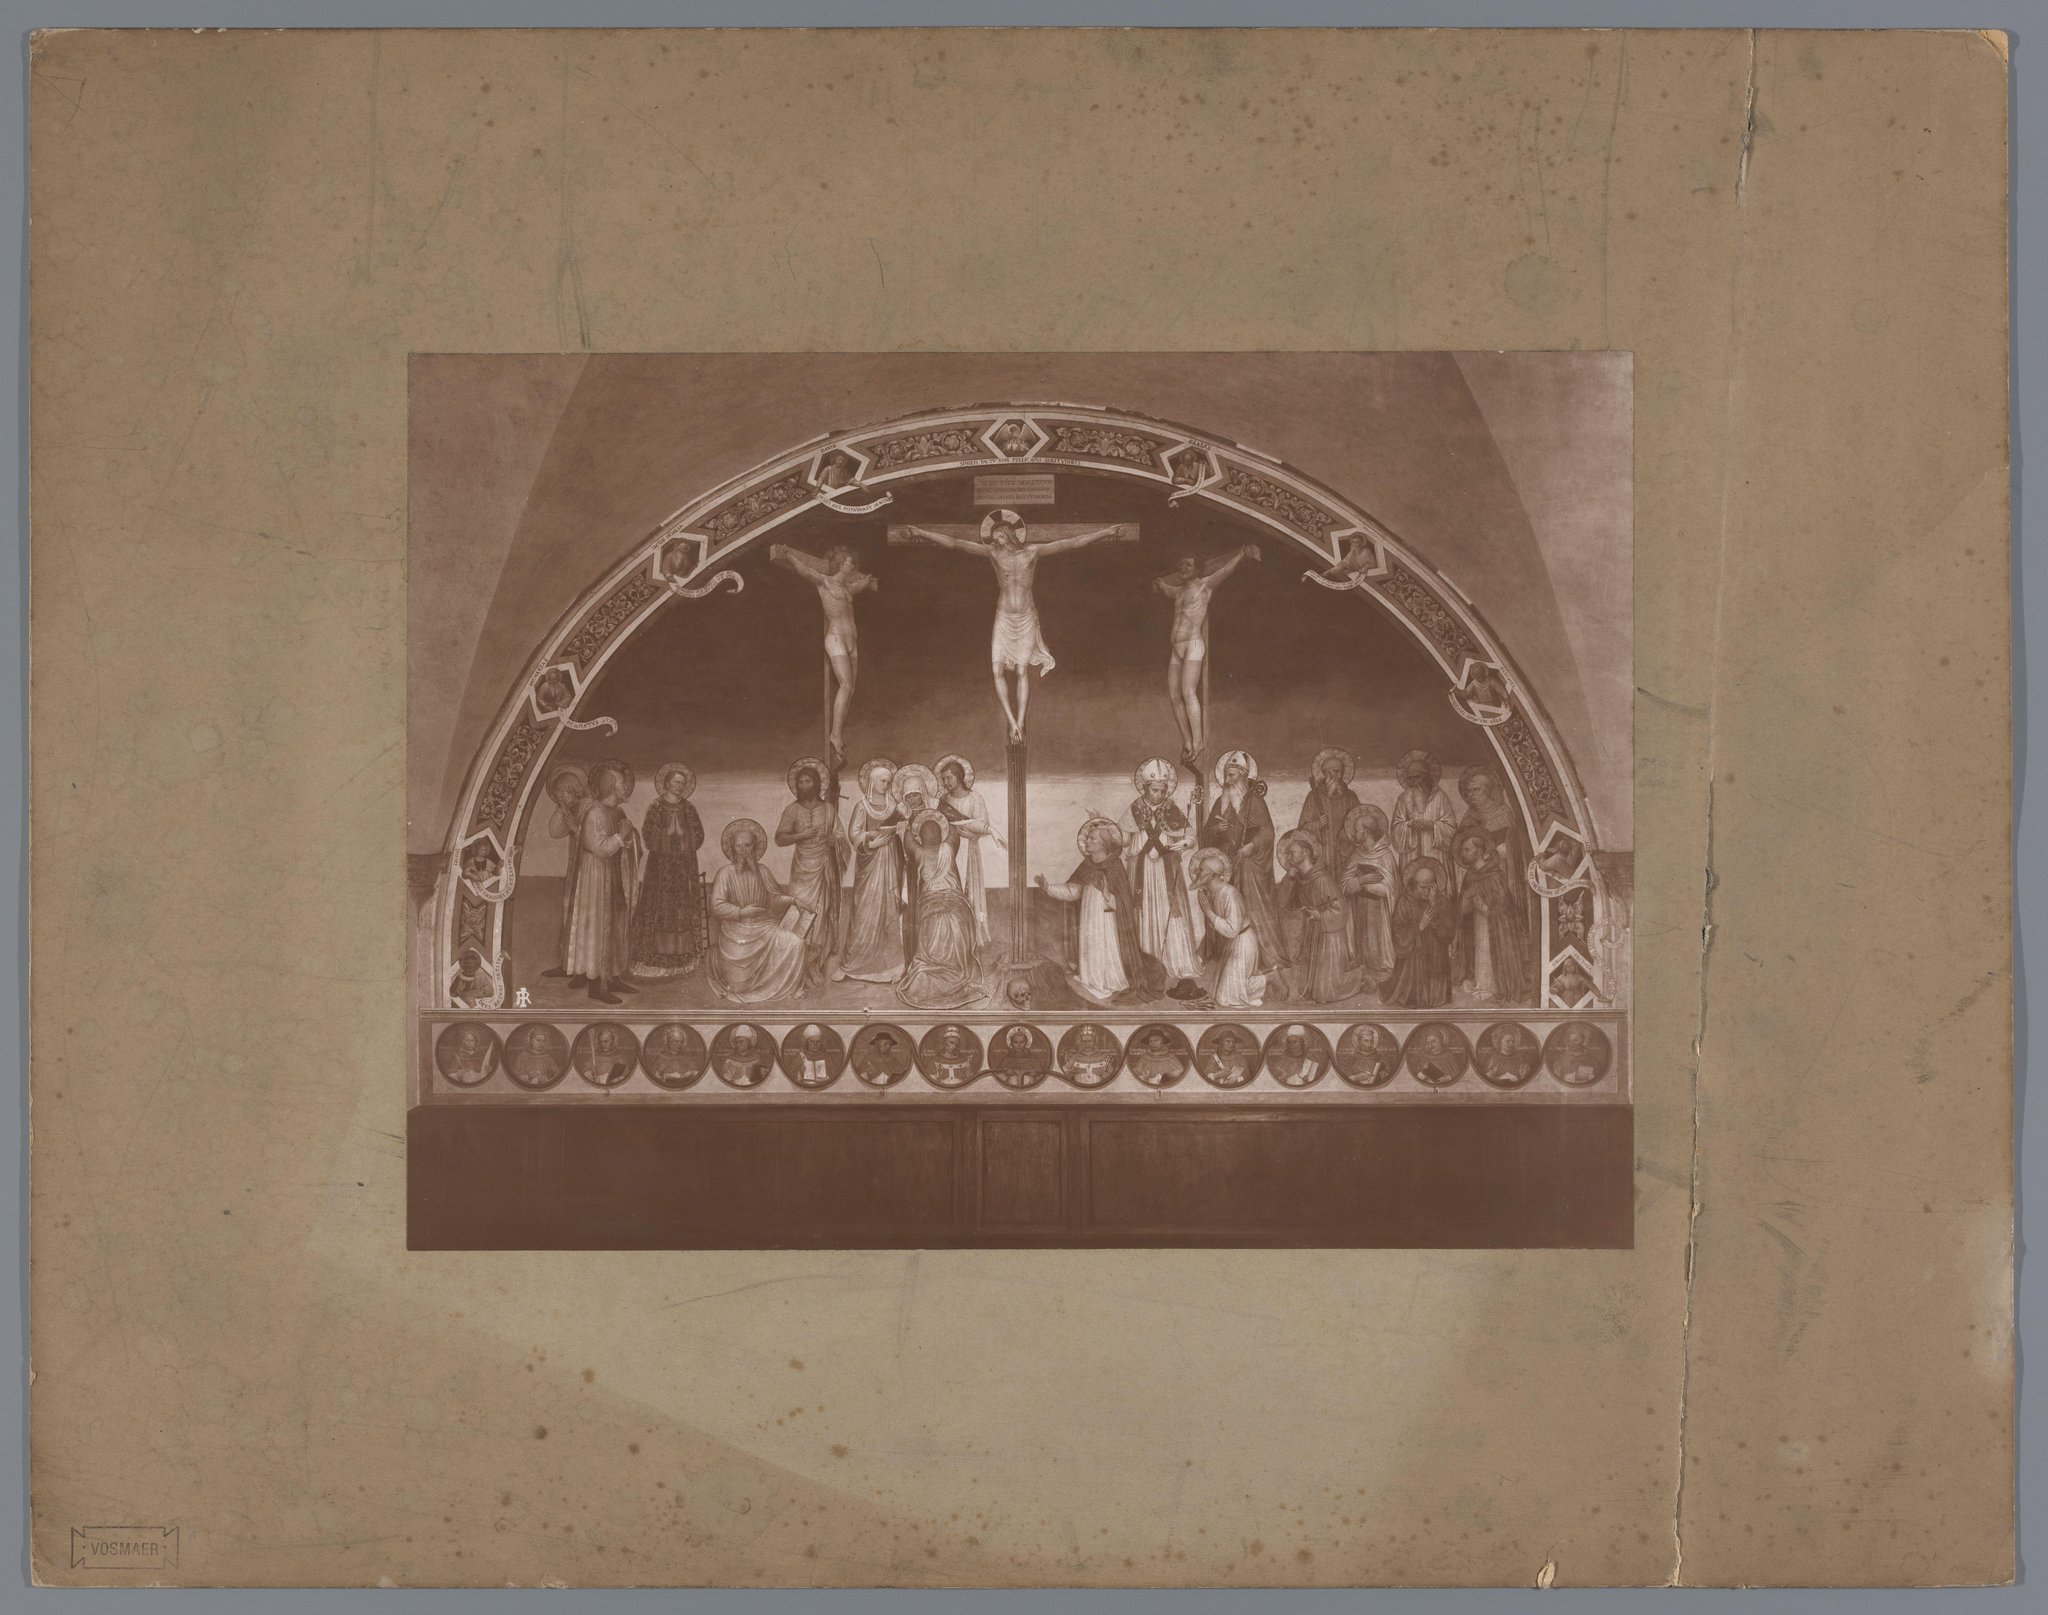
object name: photograph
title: Fotoreproductie van een fresco voorstellende Christus aan het kruis, van Fra Angelico in de San Marco te Florence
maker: Anonymous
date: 1910-1930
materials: photographic support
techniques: gelatin silver print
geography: florence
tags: san marco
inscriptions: stamp: ‘VOSMAER’